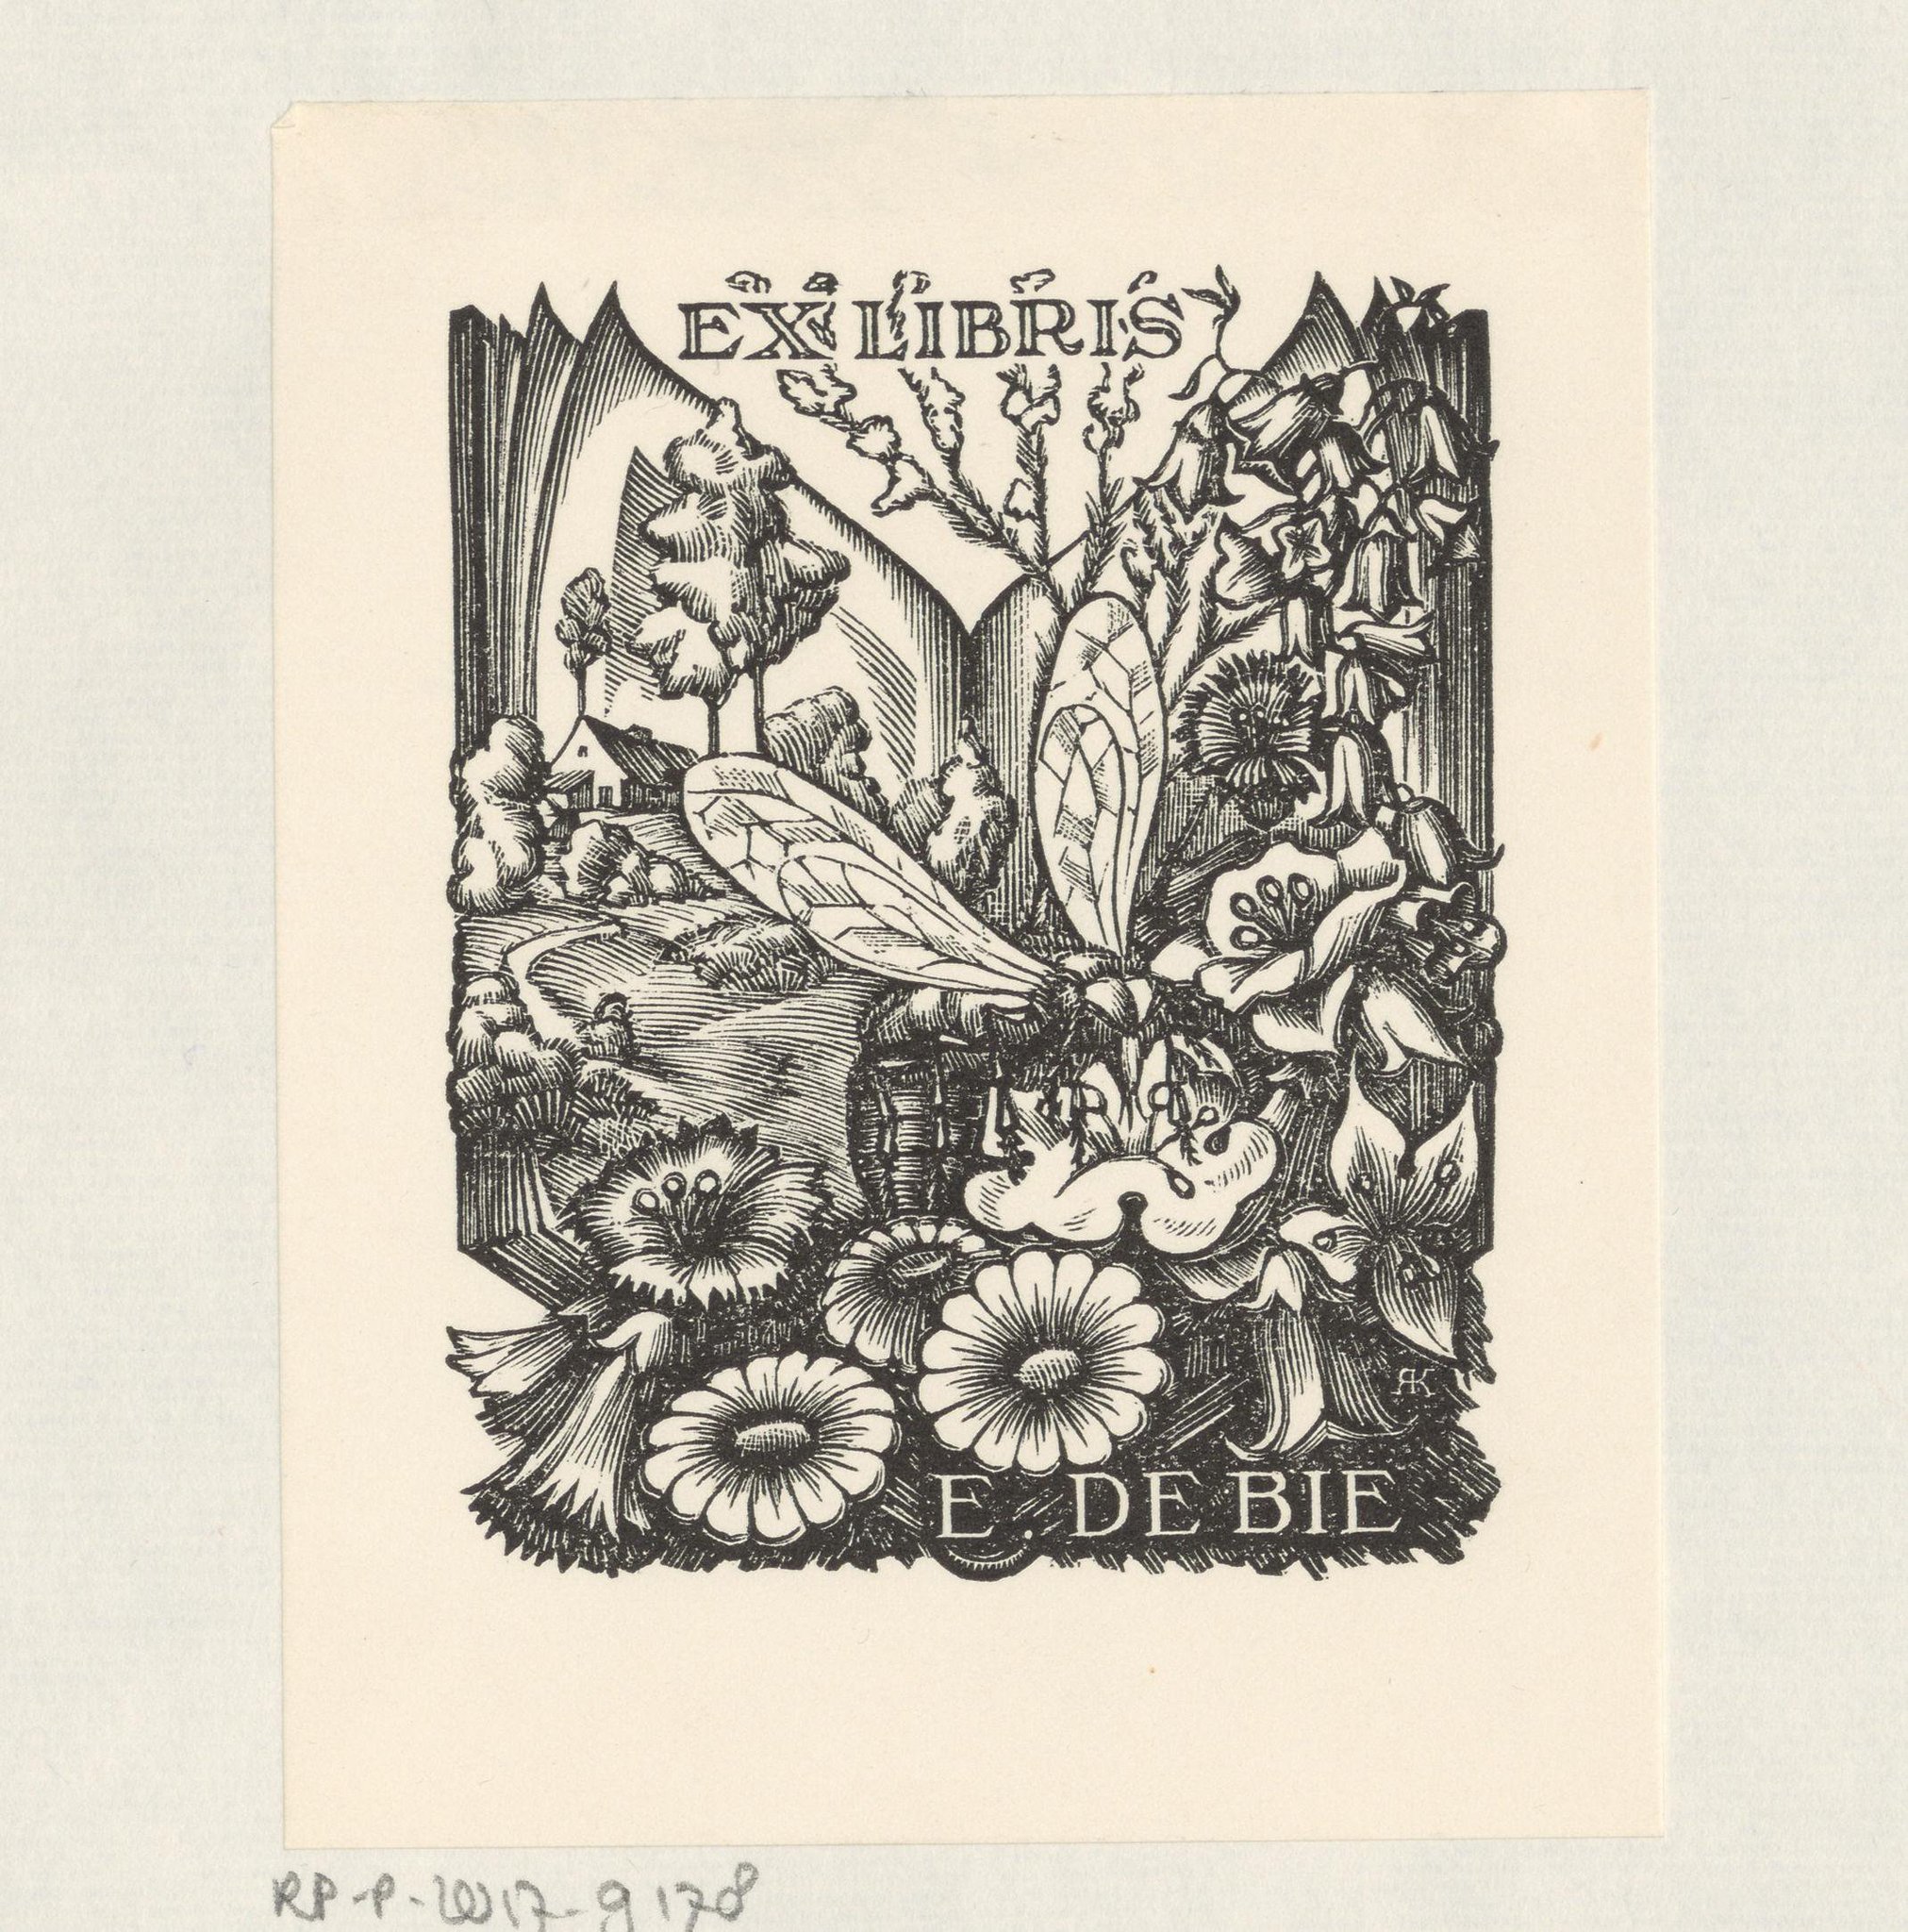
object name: bookplate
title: Ex libris van E. de Bie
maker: hendrik keuterickx (rik)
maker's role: print maker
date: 1900-1999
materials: paper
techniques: woodcut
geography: belgium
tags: flowers, book, insects